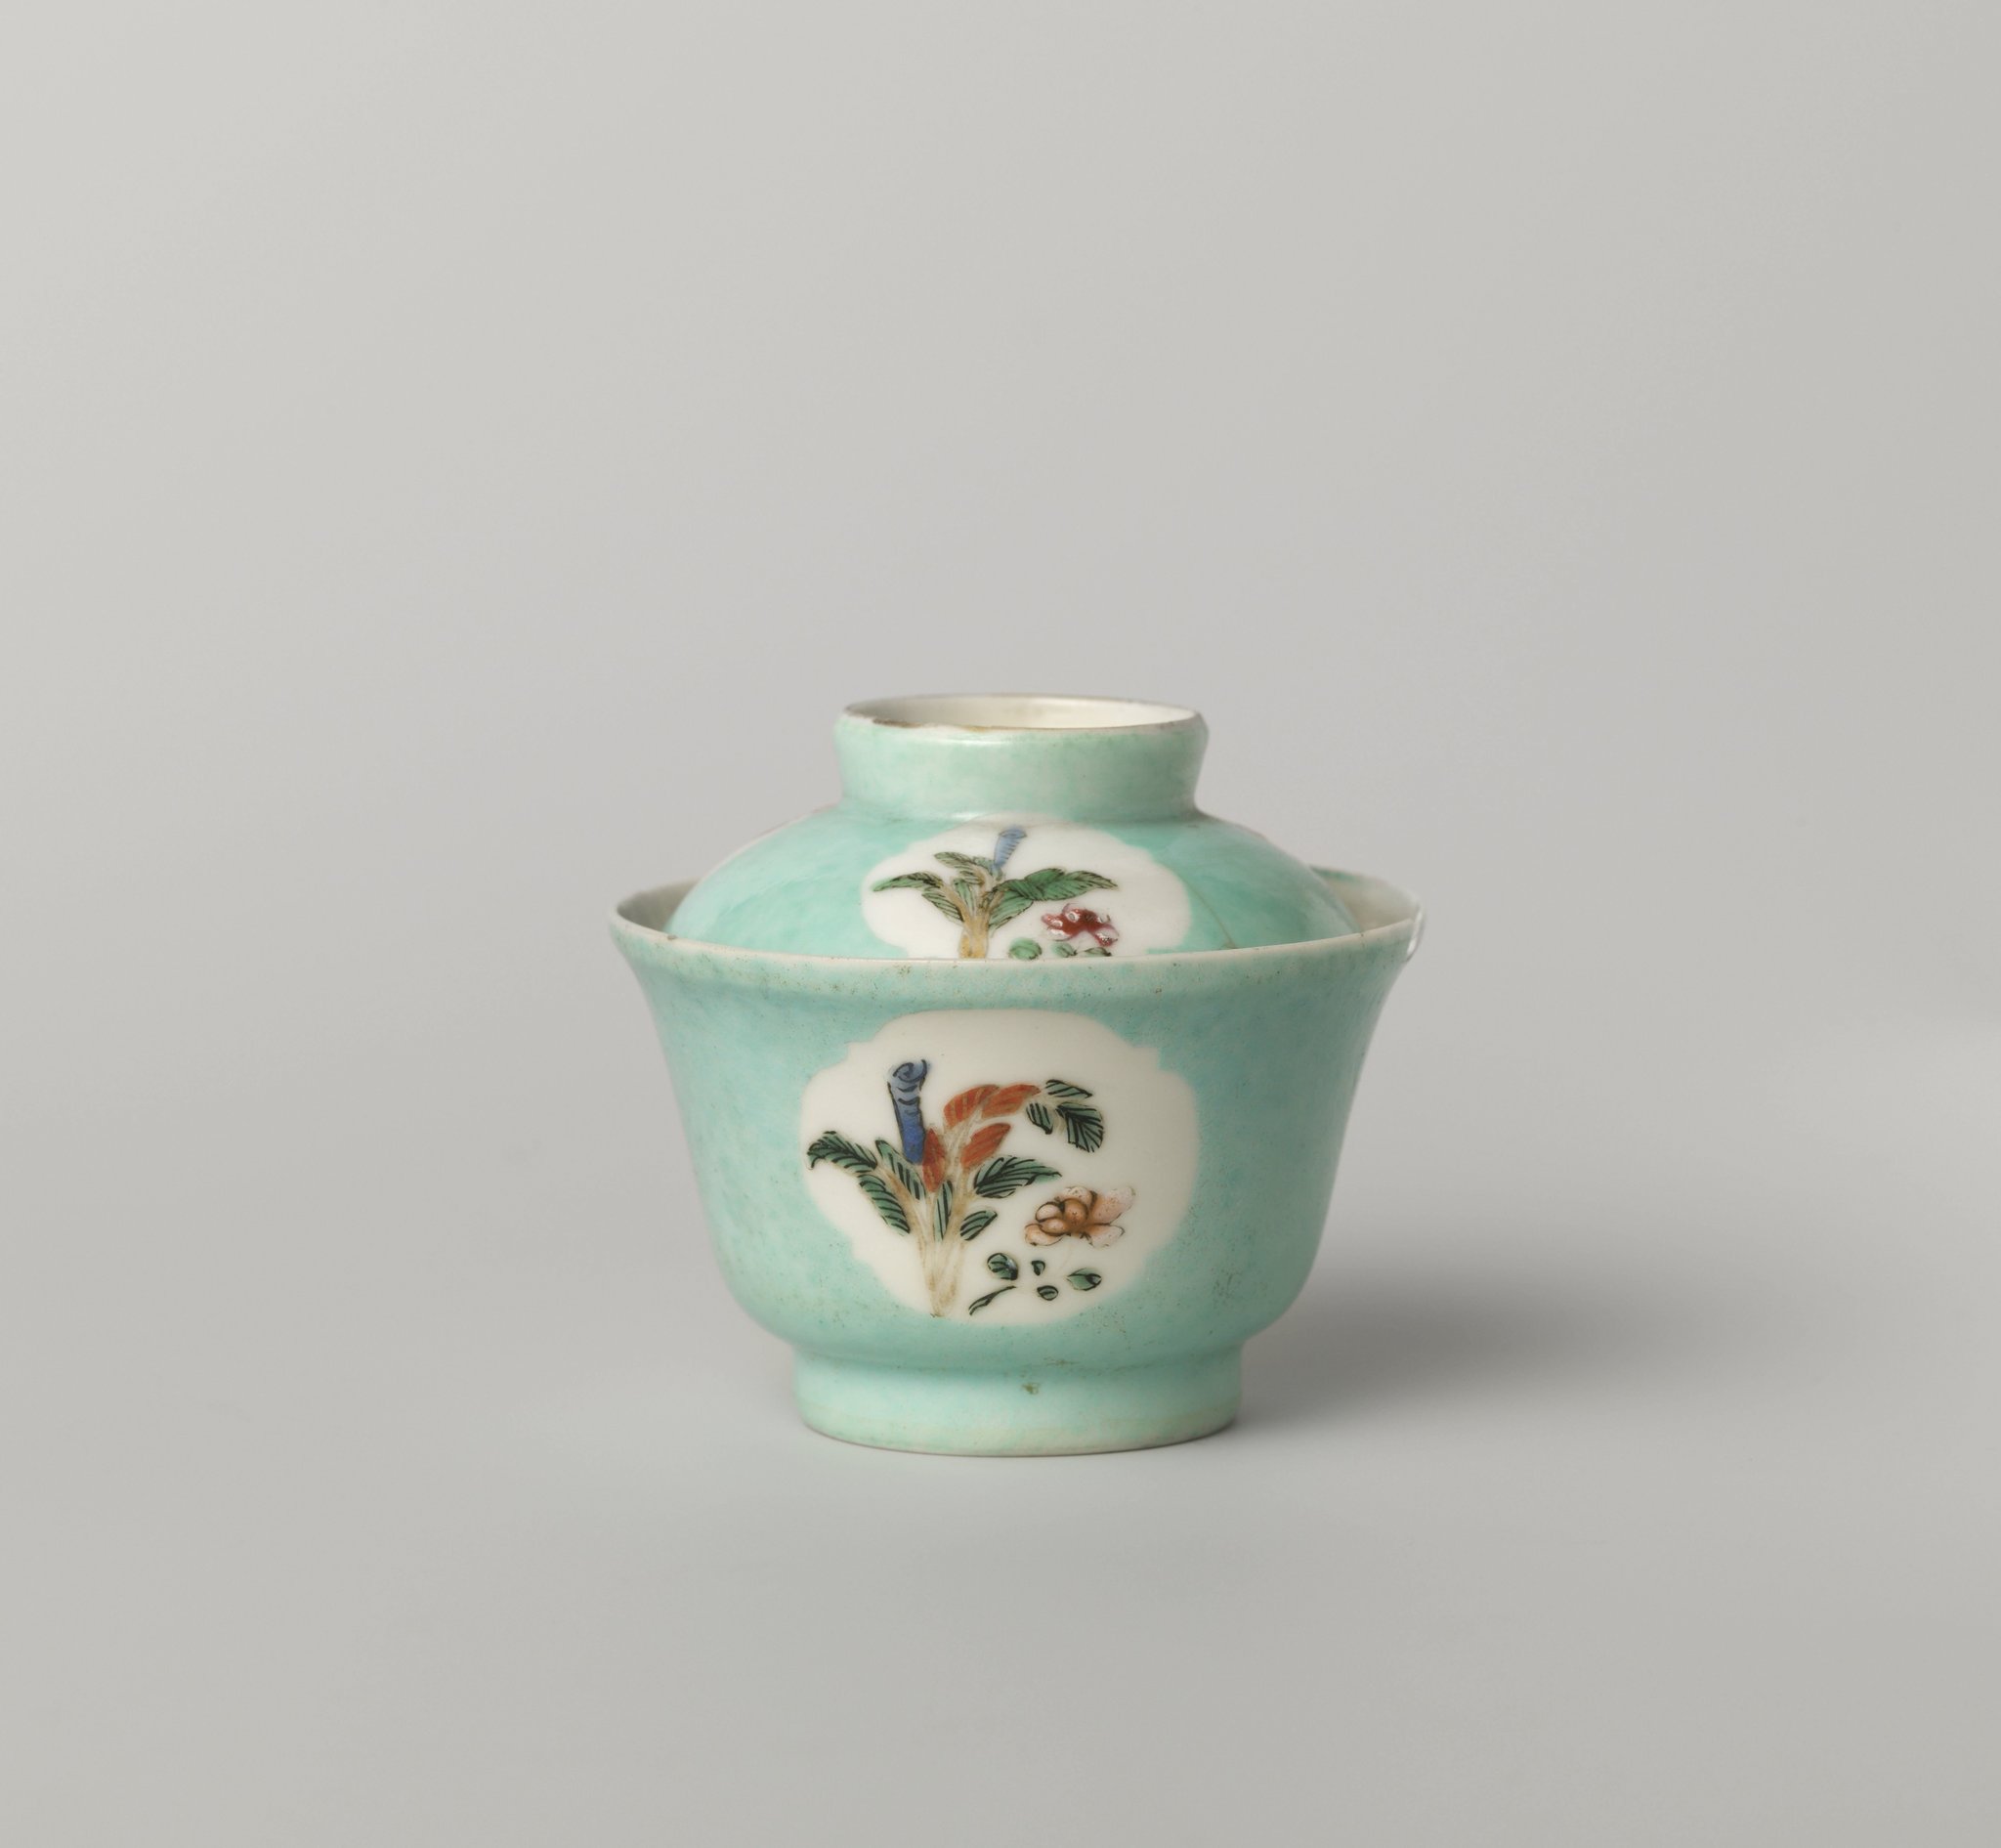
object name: cup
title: Bell-shaped covered cup with flowering plants in shaped panels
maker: Anonymous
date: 1760-1780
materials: glaze, gold, paint, porcelain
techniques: firing, gilding, turning, vitrification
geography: china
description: AK-NM-6408 Zes koppen met deksels en schotels • Famille rose porselein • Onderdeel van Royers porseleincollectie Voor enkele opmerkingen over het turquoise glazuur, zie de toelichting bij AK-NM-6409. Het Victoria and Albert Museum heeft een vergelijkbare kop en schotel met bolle (niet klokvormige, zoals hier) wanden (Inv.nr. C 73&A-1912). Het is daar gedateerd 1725-1735. Bij AK-NM-6409 is al een Delfts kopje genoemd met een vergelijkbaar glazuur, met de datering 1720-1750. Dat moet wel de periode zijn geweest waarin dit in de mode was. Twee grote kommen in de collectie van het Rijksmuseum hebben ook deze kleur aan de binnenzijde (AK-NM-6535). Zij kunnen midden 18de eeuw gedateerd worden omdat in de Engelse koninklijke collectie een identieke kom voorkomt in een goed te dateren montuur [Ayers 2016, vol. I, nr. 715]. Deze koppen en schotels horen dus bij de porseleinverzameling. Dit in tegenstelling tot de vele koffie- en theeserviezen en losse series theegoed die volgens de boedelbeschrijving opgemaakt na het overlijden van de weduwe Royer, ergens een plek in huis hadden. Bronnen: John Ayers, Chinese and Japanese works of art in the collection of Her Majesty The Queen, Londen, 2016.